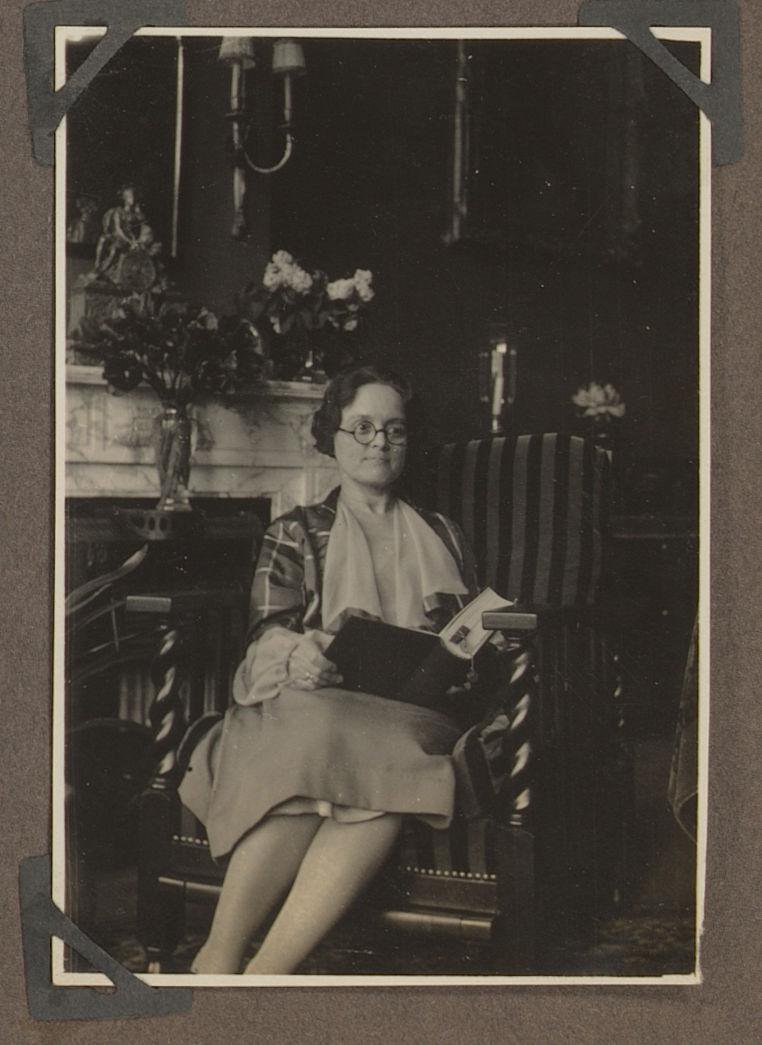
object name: photograph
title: Portret van Henriëtte Wassink, lezend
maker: Anonymous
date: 1930-1935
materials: paper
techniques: gelatin silver print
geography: netherlands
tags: batavia, the hague, henriëtte wassink, adult woman, reading, historical persons, netherlands